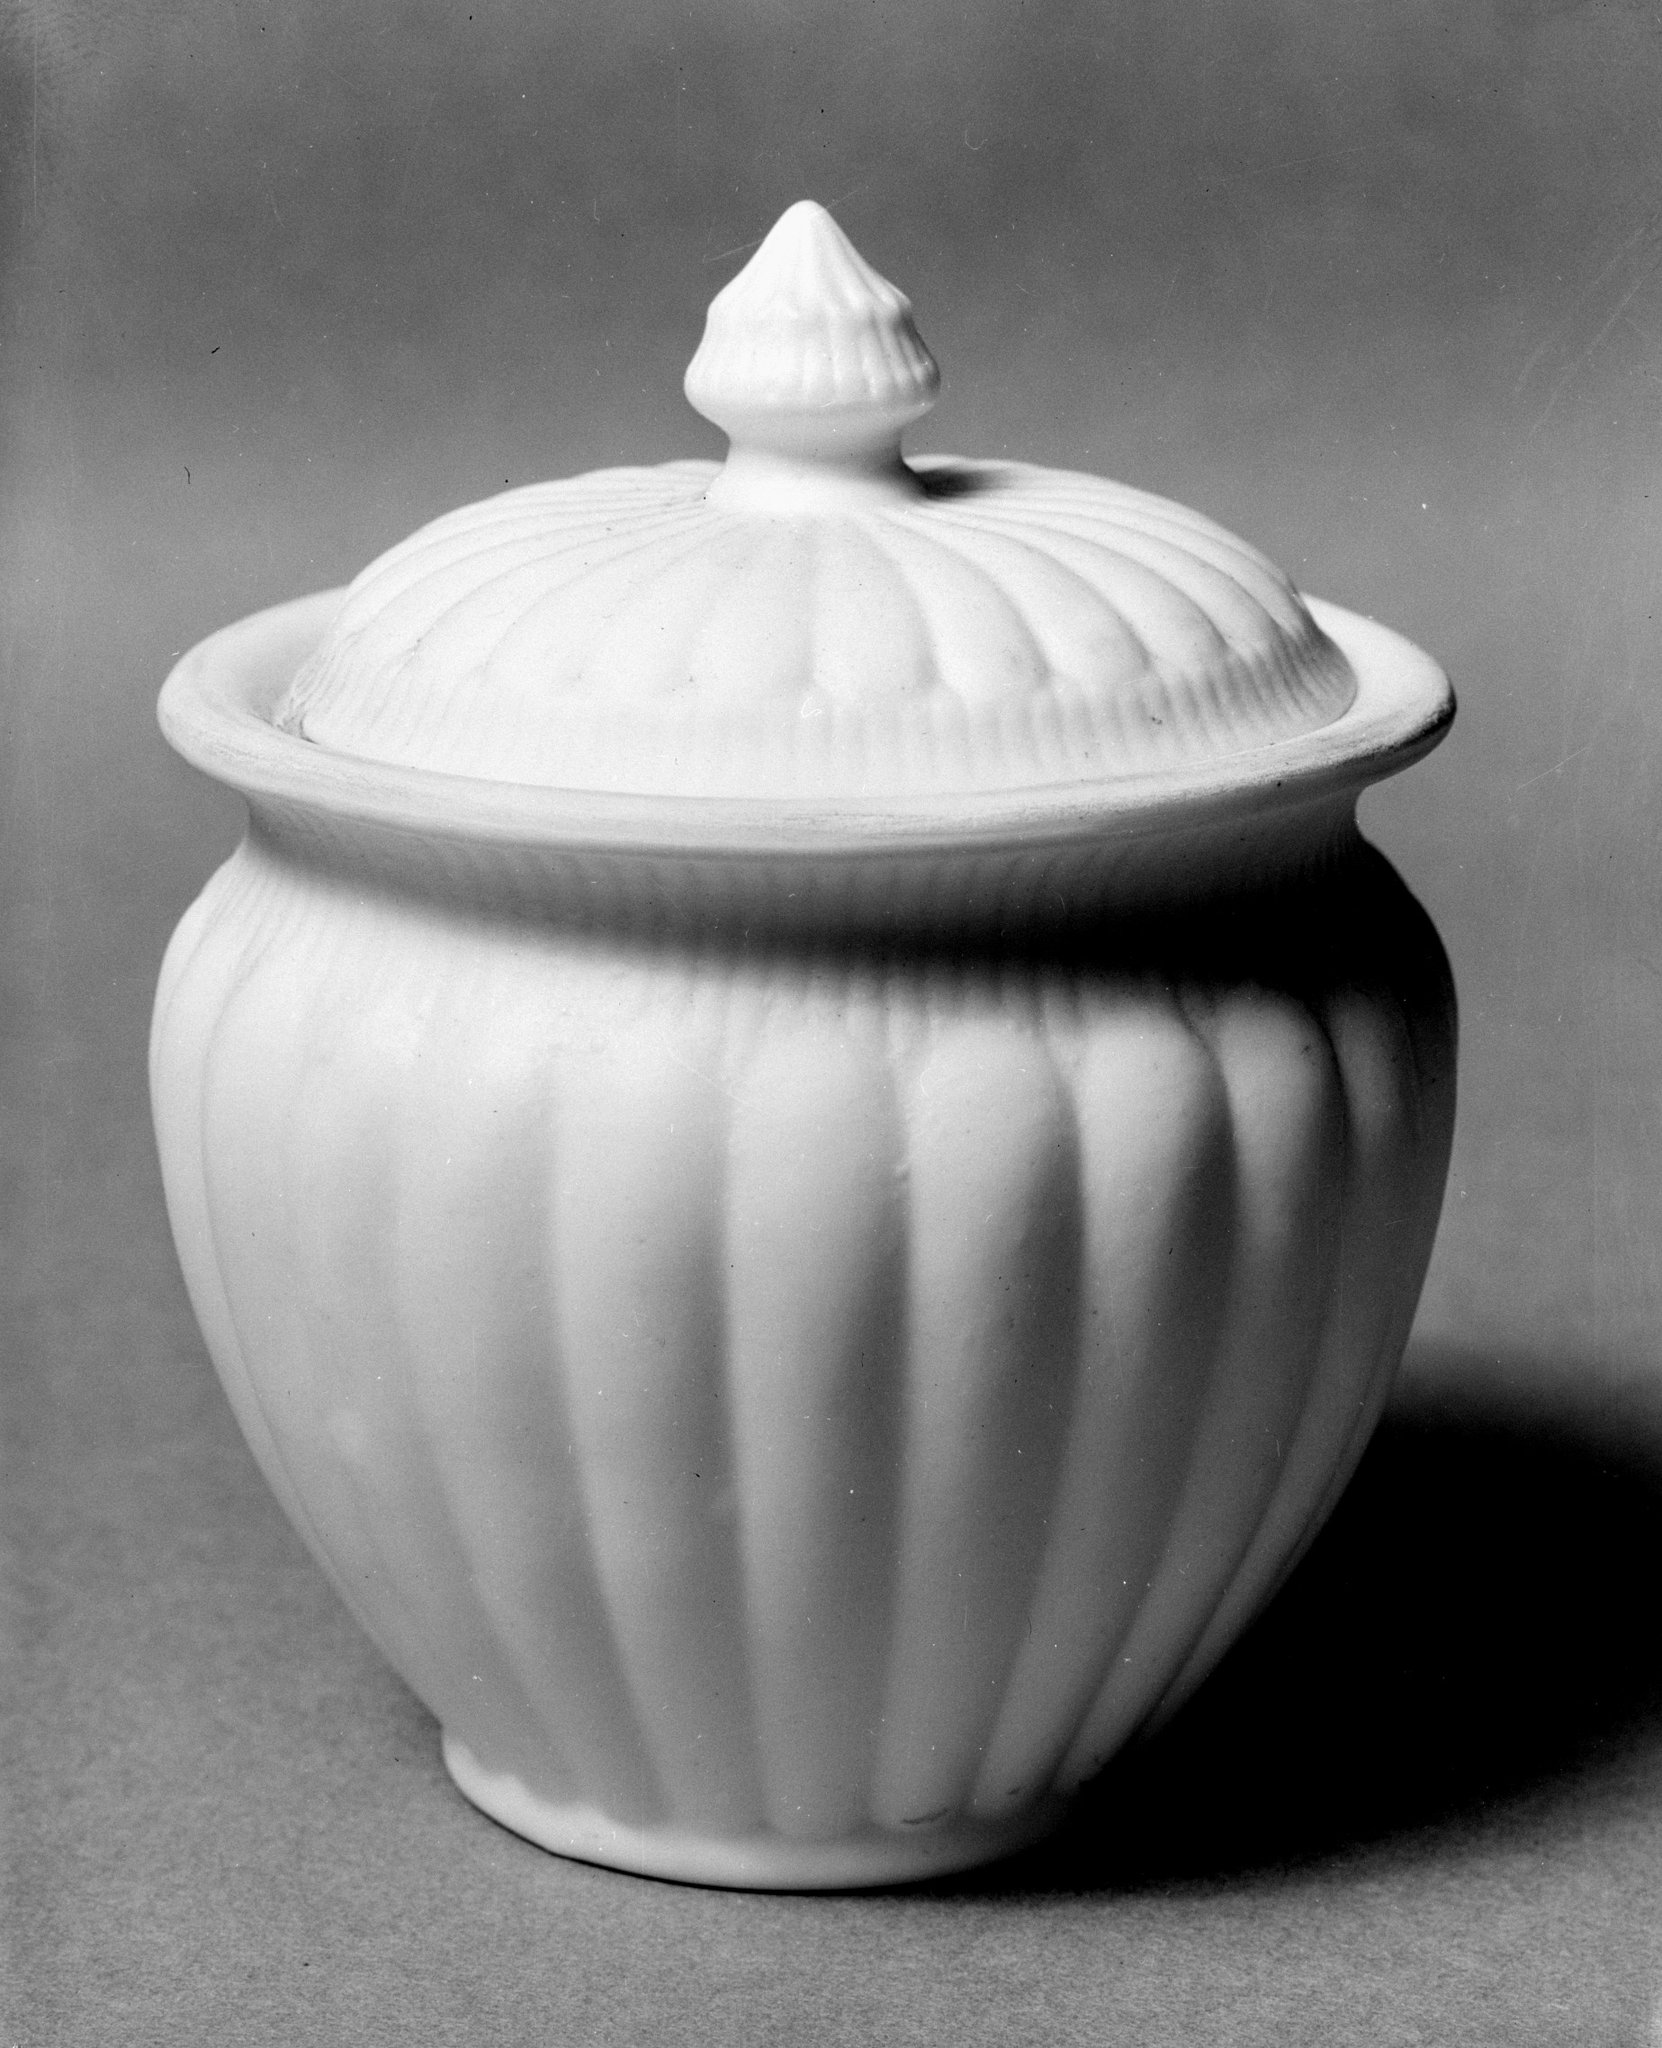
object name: jar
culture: american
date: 1830-1870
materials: porcelain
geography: united states